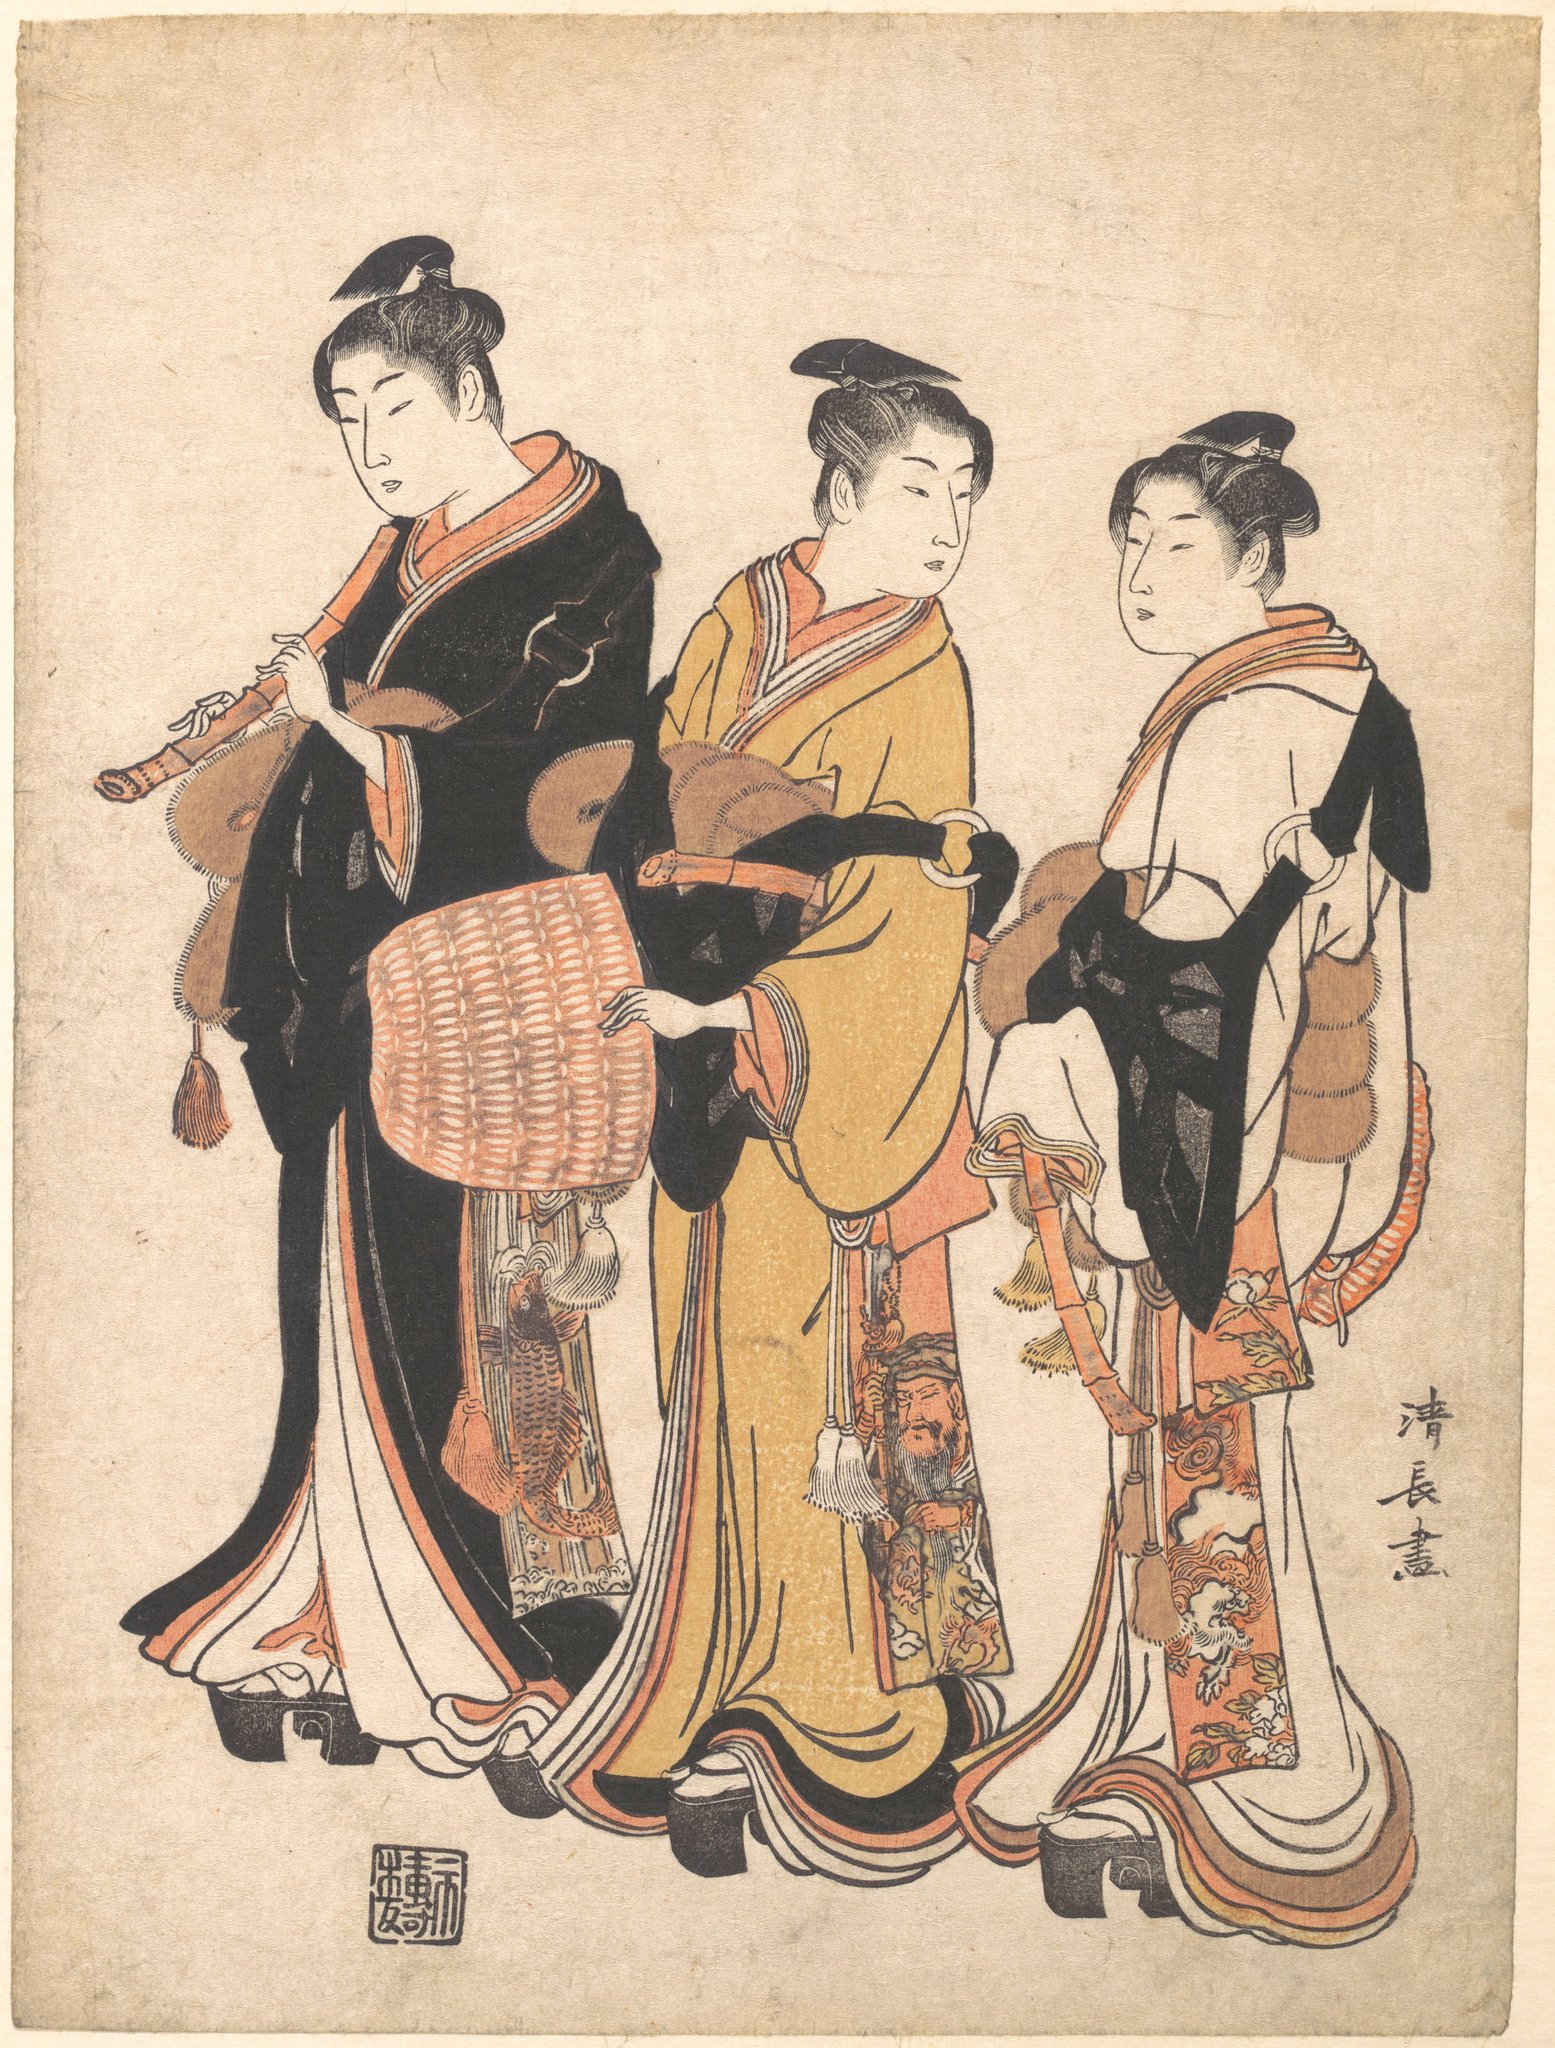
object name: print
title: Three Young Women Masquerading as Komuso (Strolling Minstrel)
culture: japanese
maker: torii kiyonaga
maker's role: artist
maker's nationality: japanese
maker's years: 1752-1815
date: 1778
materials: ink, paper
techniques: woodblock print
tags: musical instruments,women